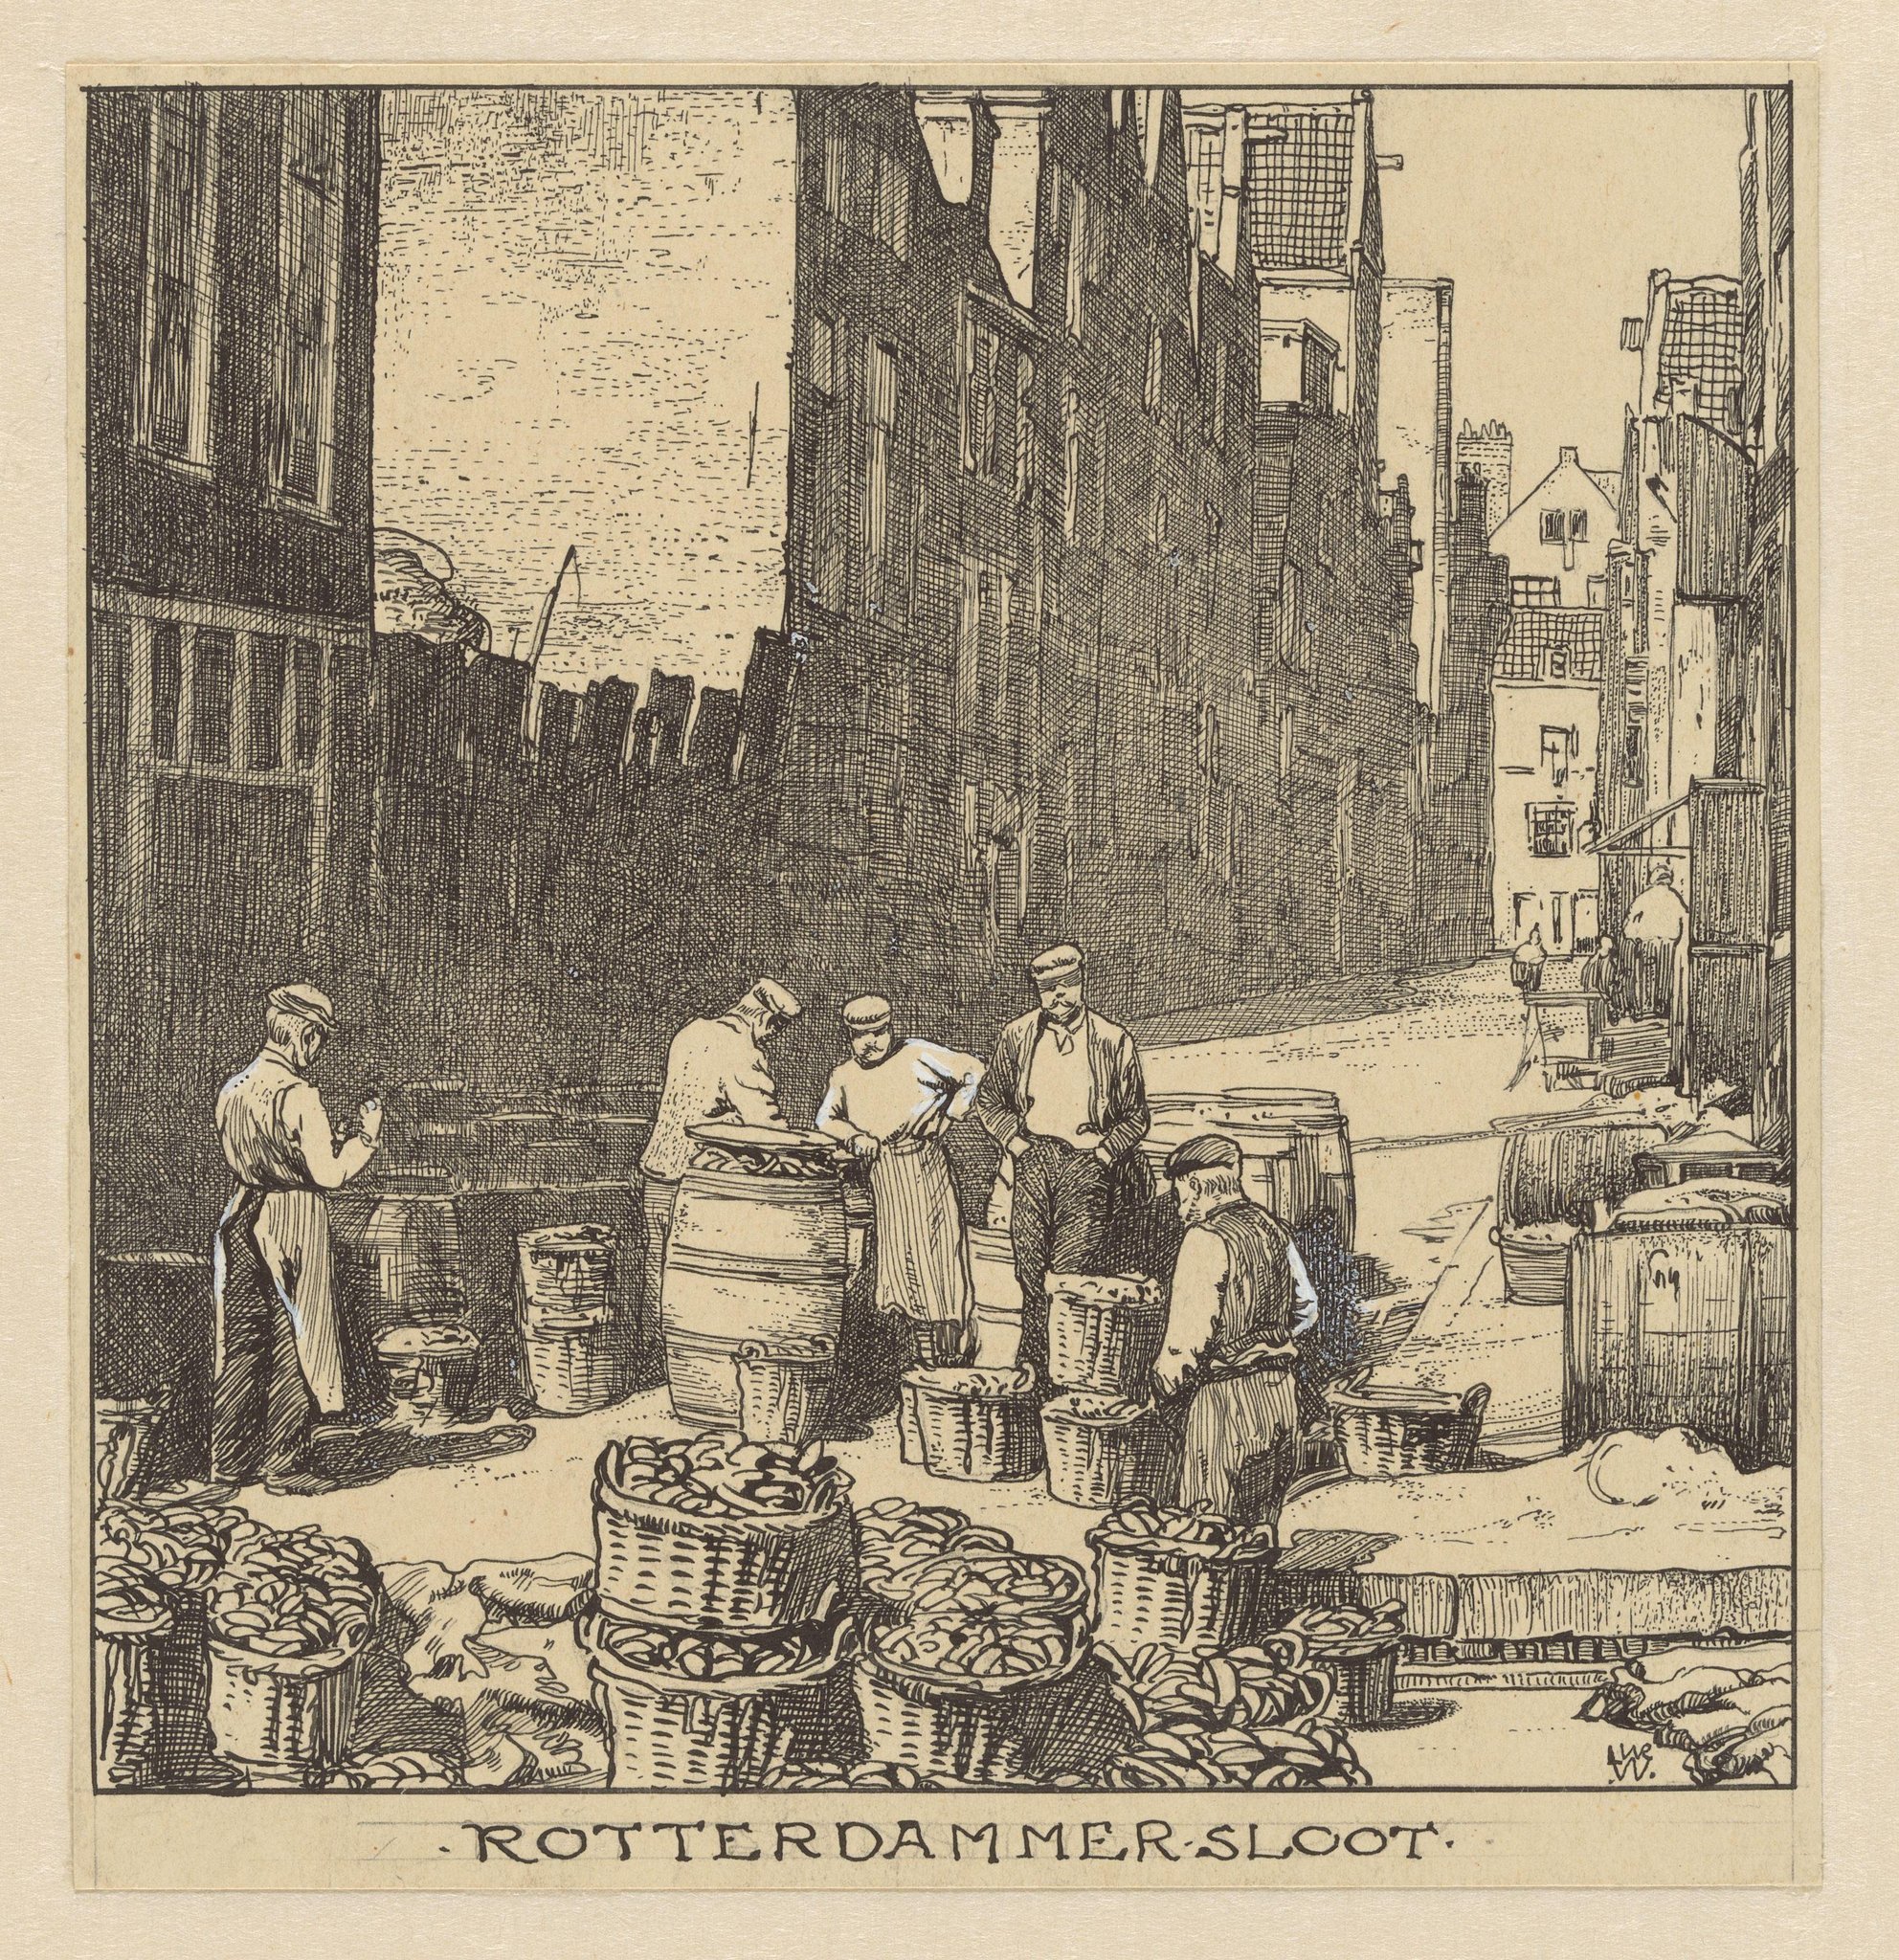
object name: drawing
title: De Rotterdammer Sloot te Amsterdam, gedempt in 1867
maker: willem wenckebach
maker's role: designer, draughtsman, painter, print maker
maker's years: 1860-1937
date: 1870-1926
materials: paint, ink, paper, pencil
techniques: pen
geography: amsterdam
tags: street